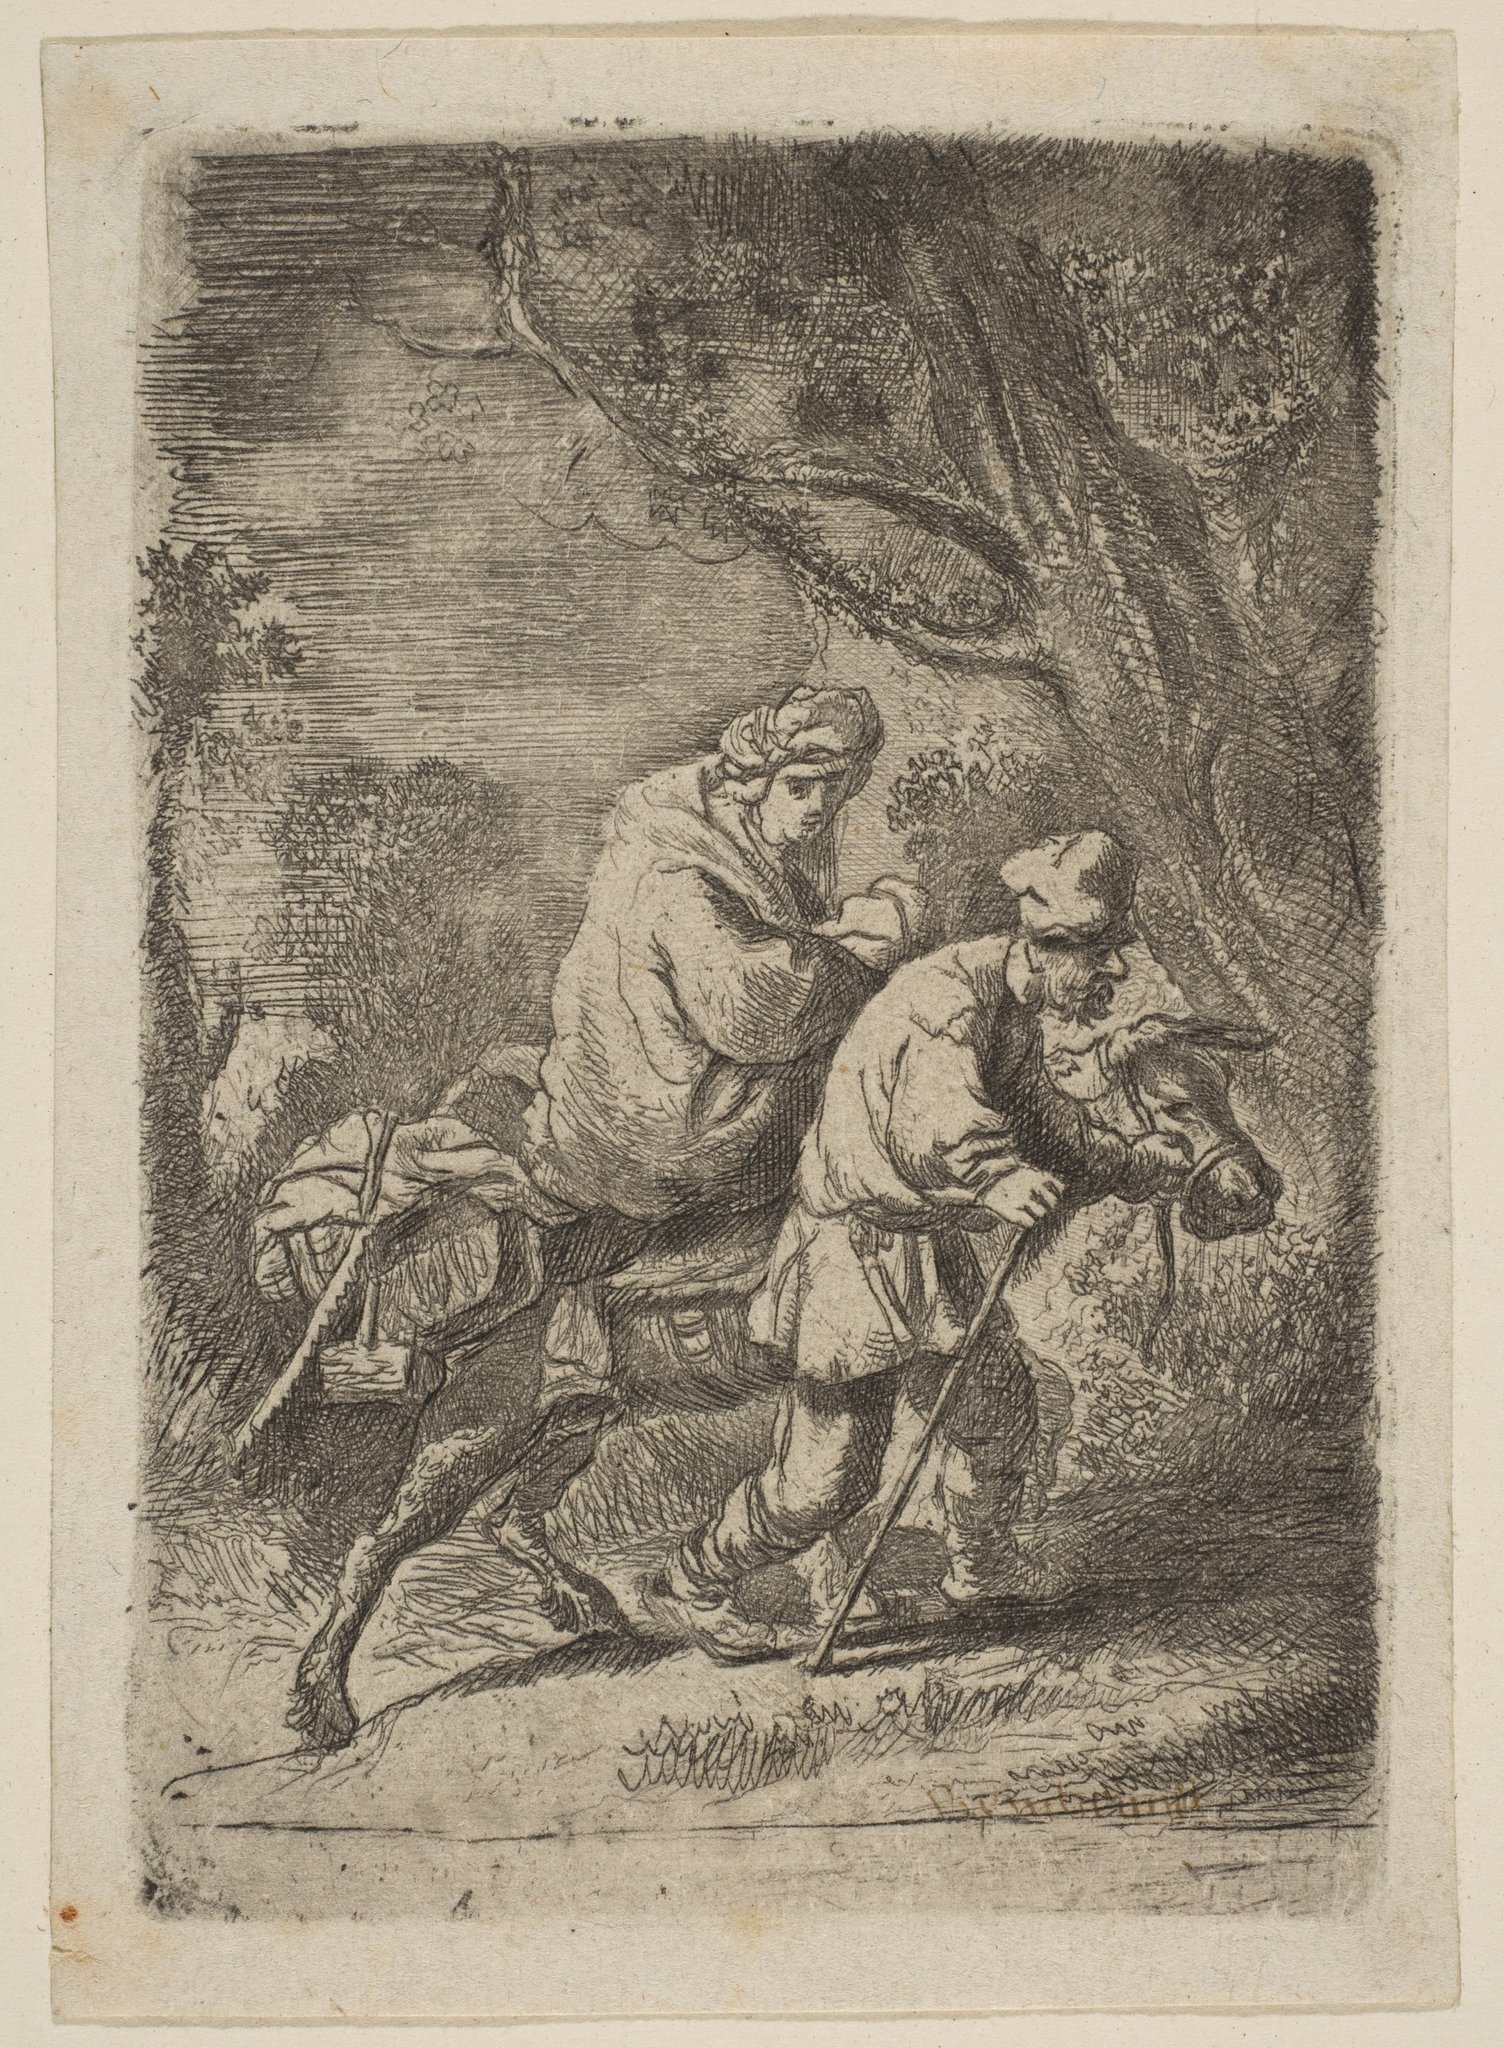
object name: print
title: The Flight into Egypt: Small Plate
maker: claude henri watelet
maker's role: artist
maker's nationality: french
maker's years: 1714-1789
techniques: etching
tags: donkeys,holy family,flight into egypt